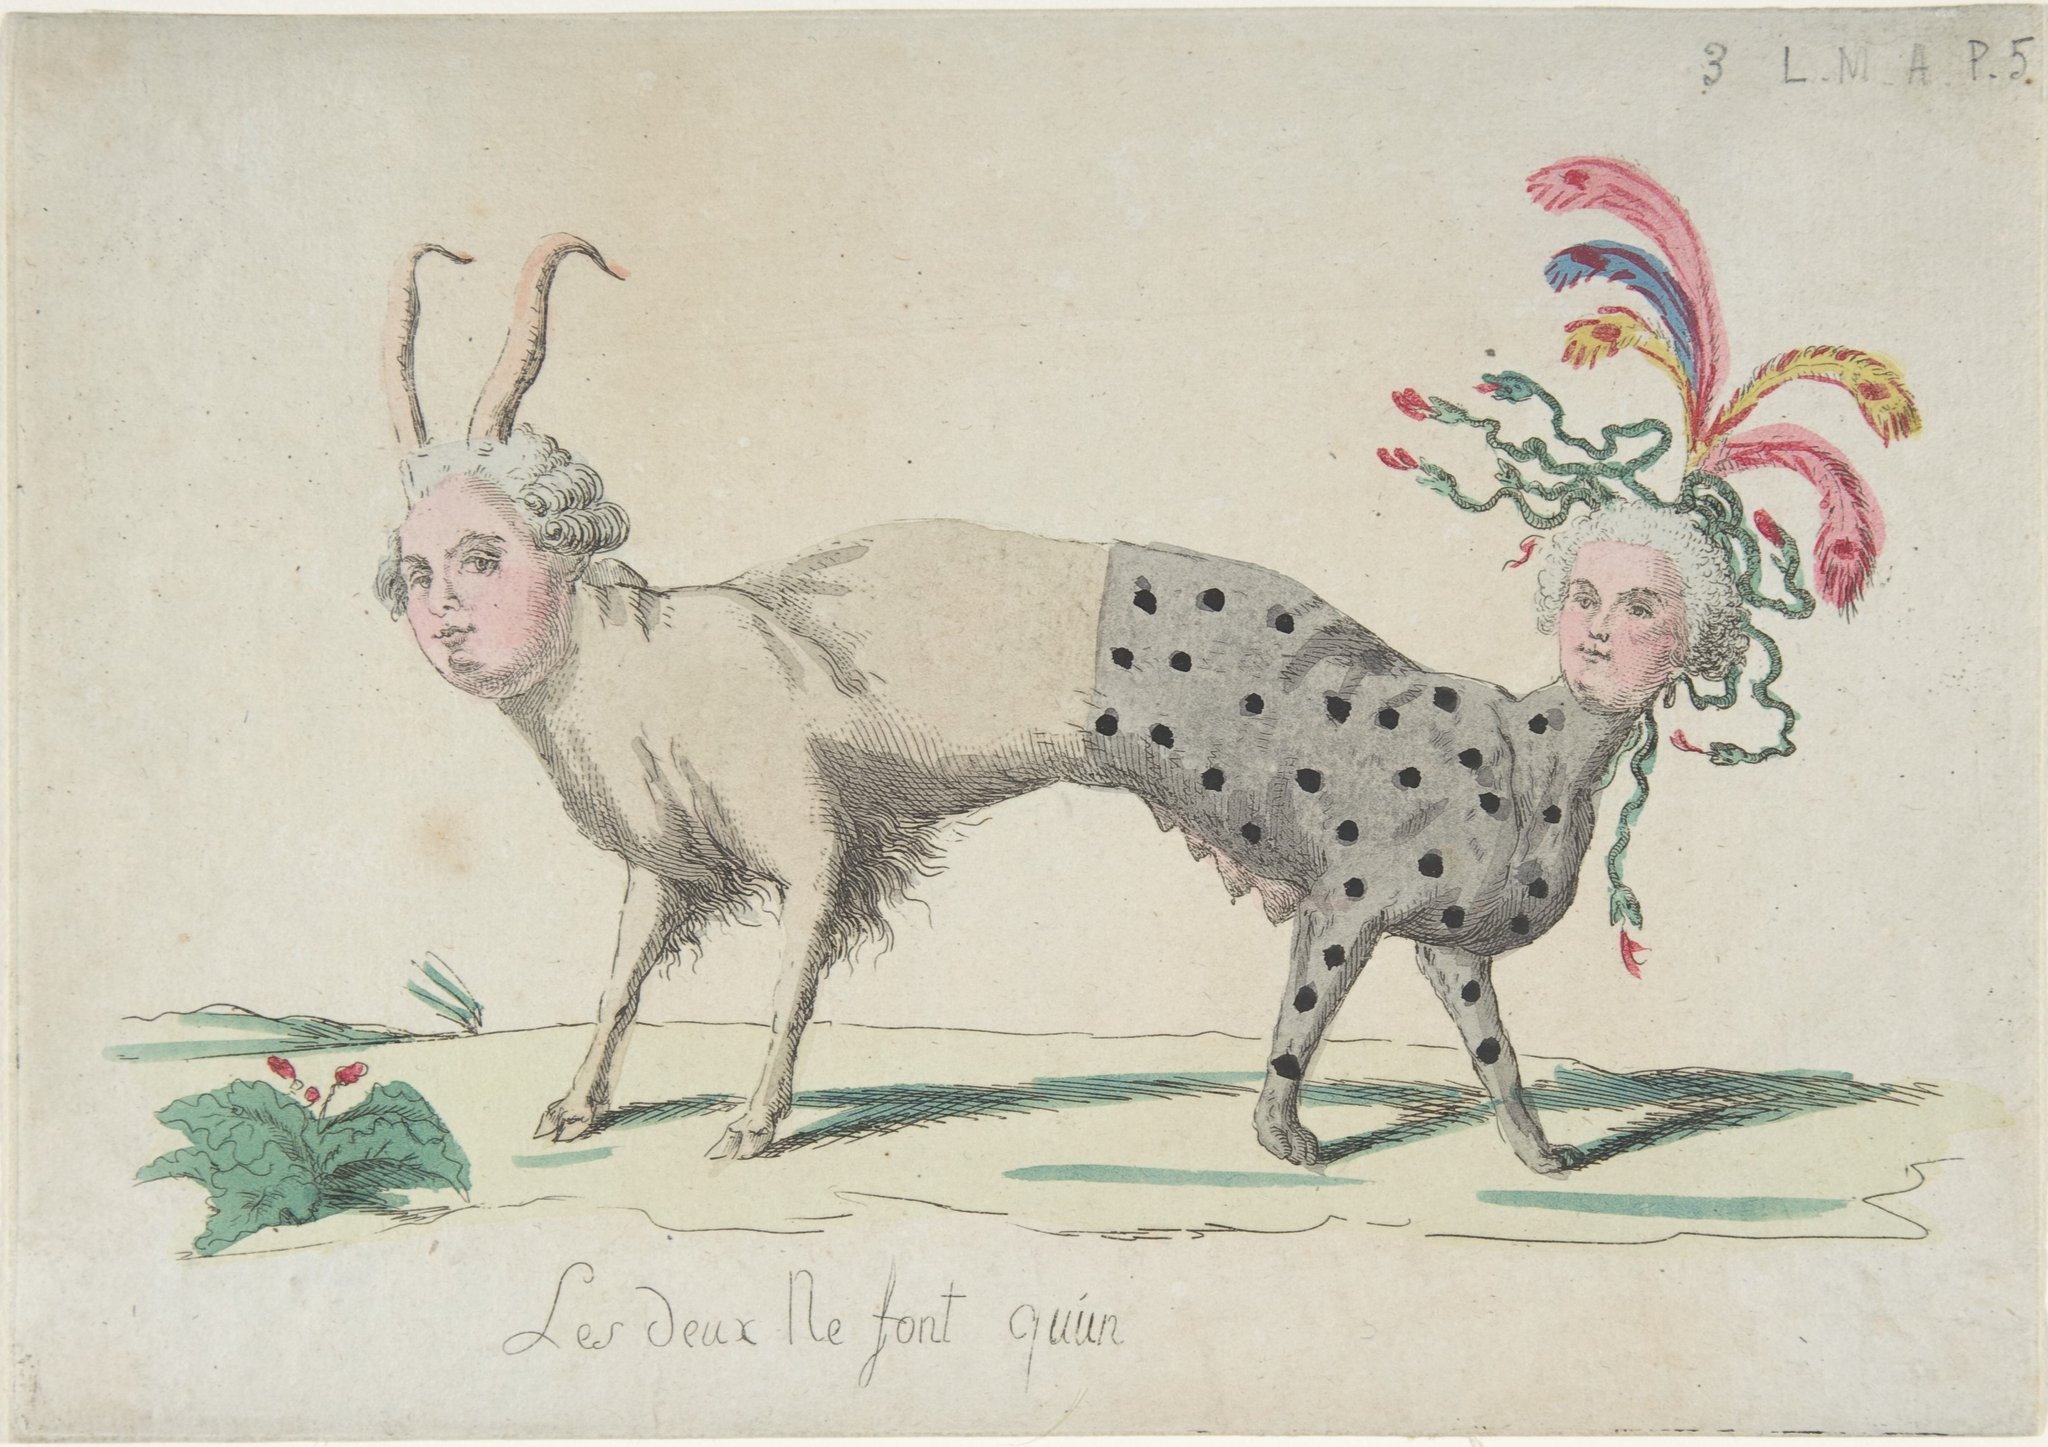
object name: print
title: The Two Are But One (Les deux ne font qu'un)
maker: anonymous, french, 18th century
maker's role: artist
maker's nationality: french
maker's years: 1700-1800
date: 1767-1800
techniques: etching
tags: satire